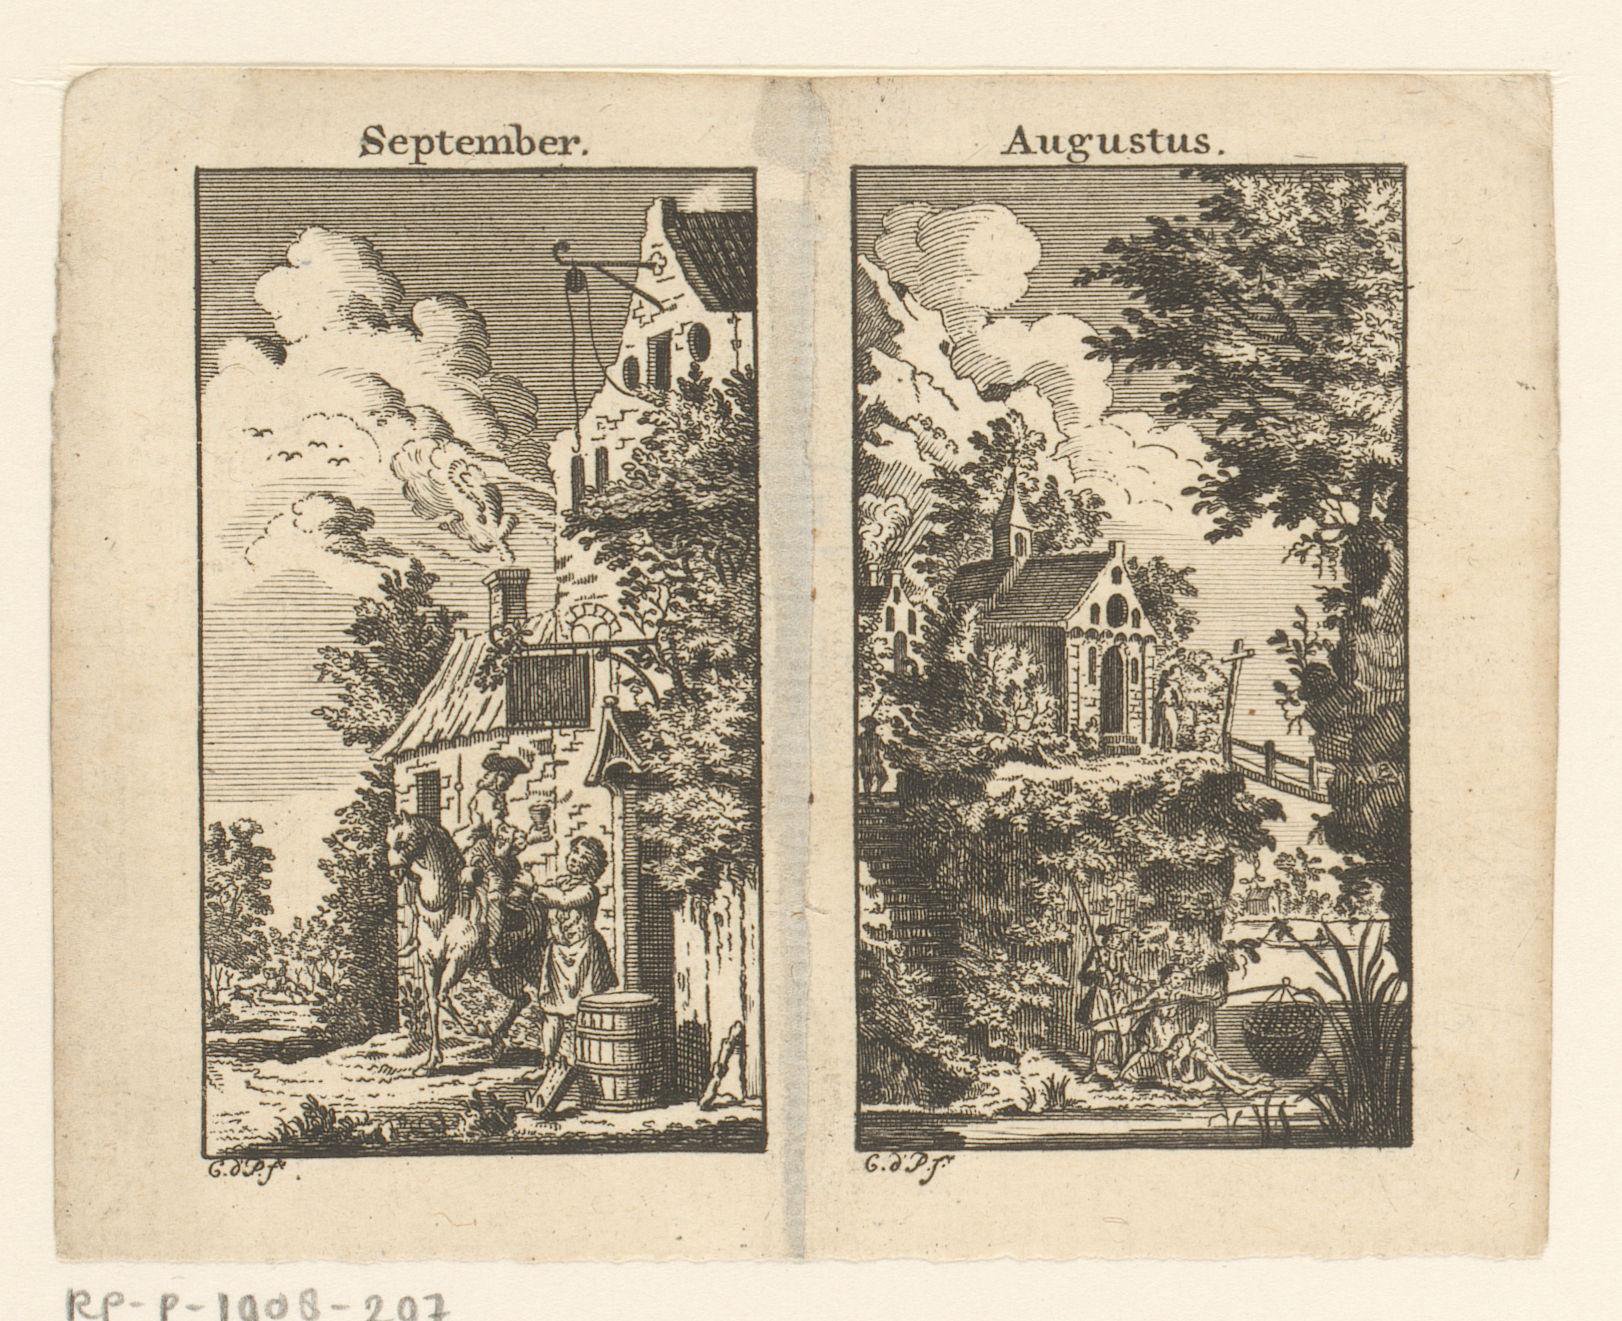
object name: print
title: Augustus en september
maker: monogrammist gdp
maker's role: print maker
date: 1700-1799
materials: paper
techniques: etching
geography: low countries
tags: the twelve months represented by landscapes (+ with scenes showing human occupations ~ seasons and months), august and september ~ human activities (year divided into six seasons) (+ with different concepts ~ seasons and months), fishing (sports)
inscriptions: collector's mark: Lugt 2228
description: September: Een man zit achterstevoren op een paard voor een huis en houdt een beker vast. Voor hem staat een vrouw. Augustus: Drie vissende figuren onder een kapel op een rots.